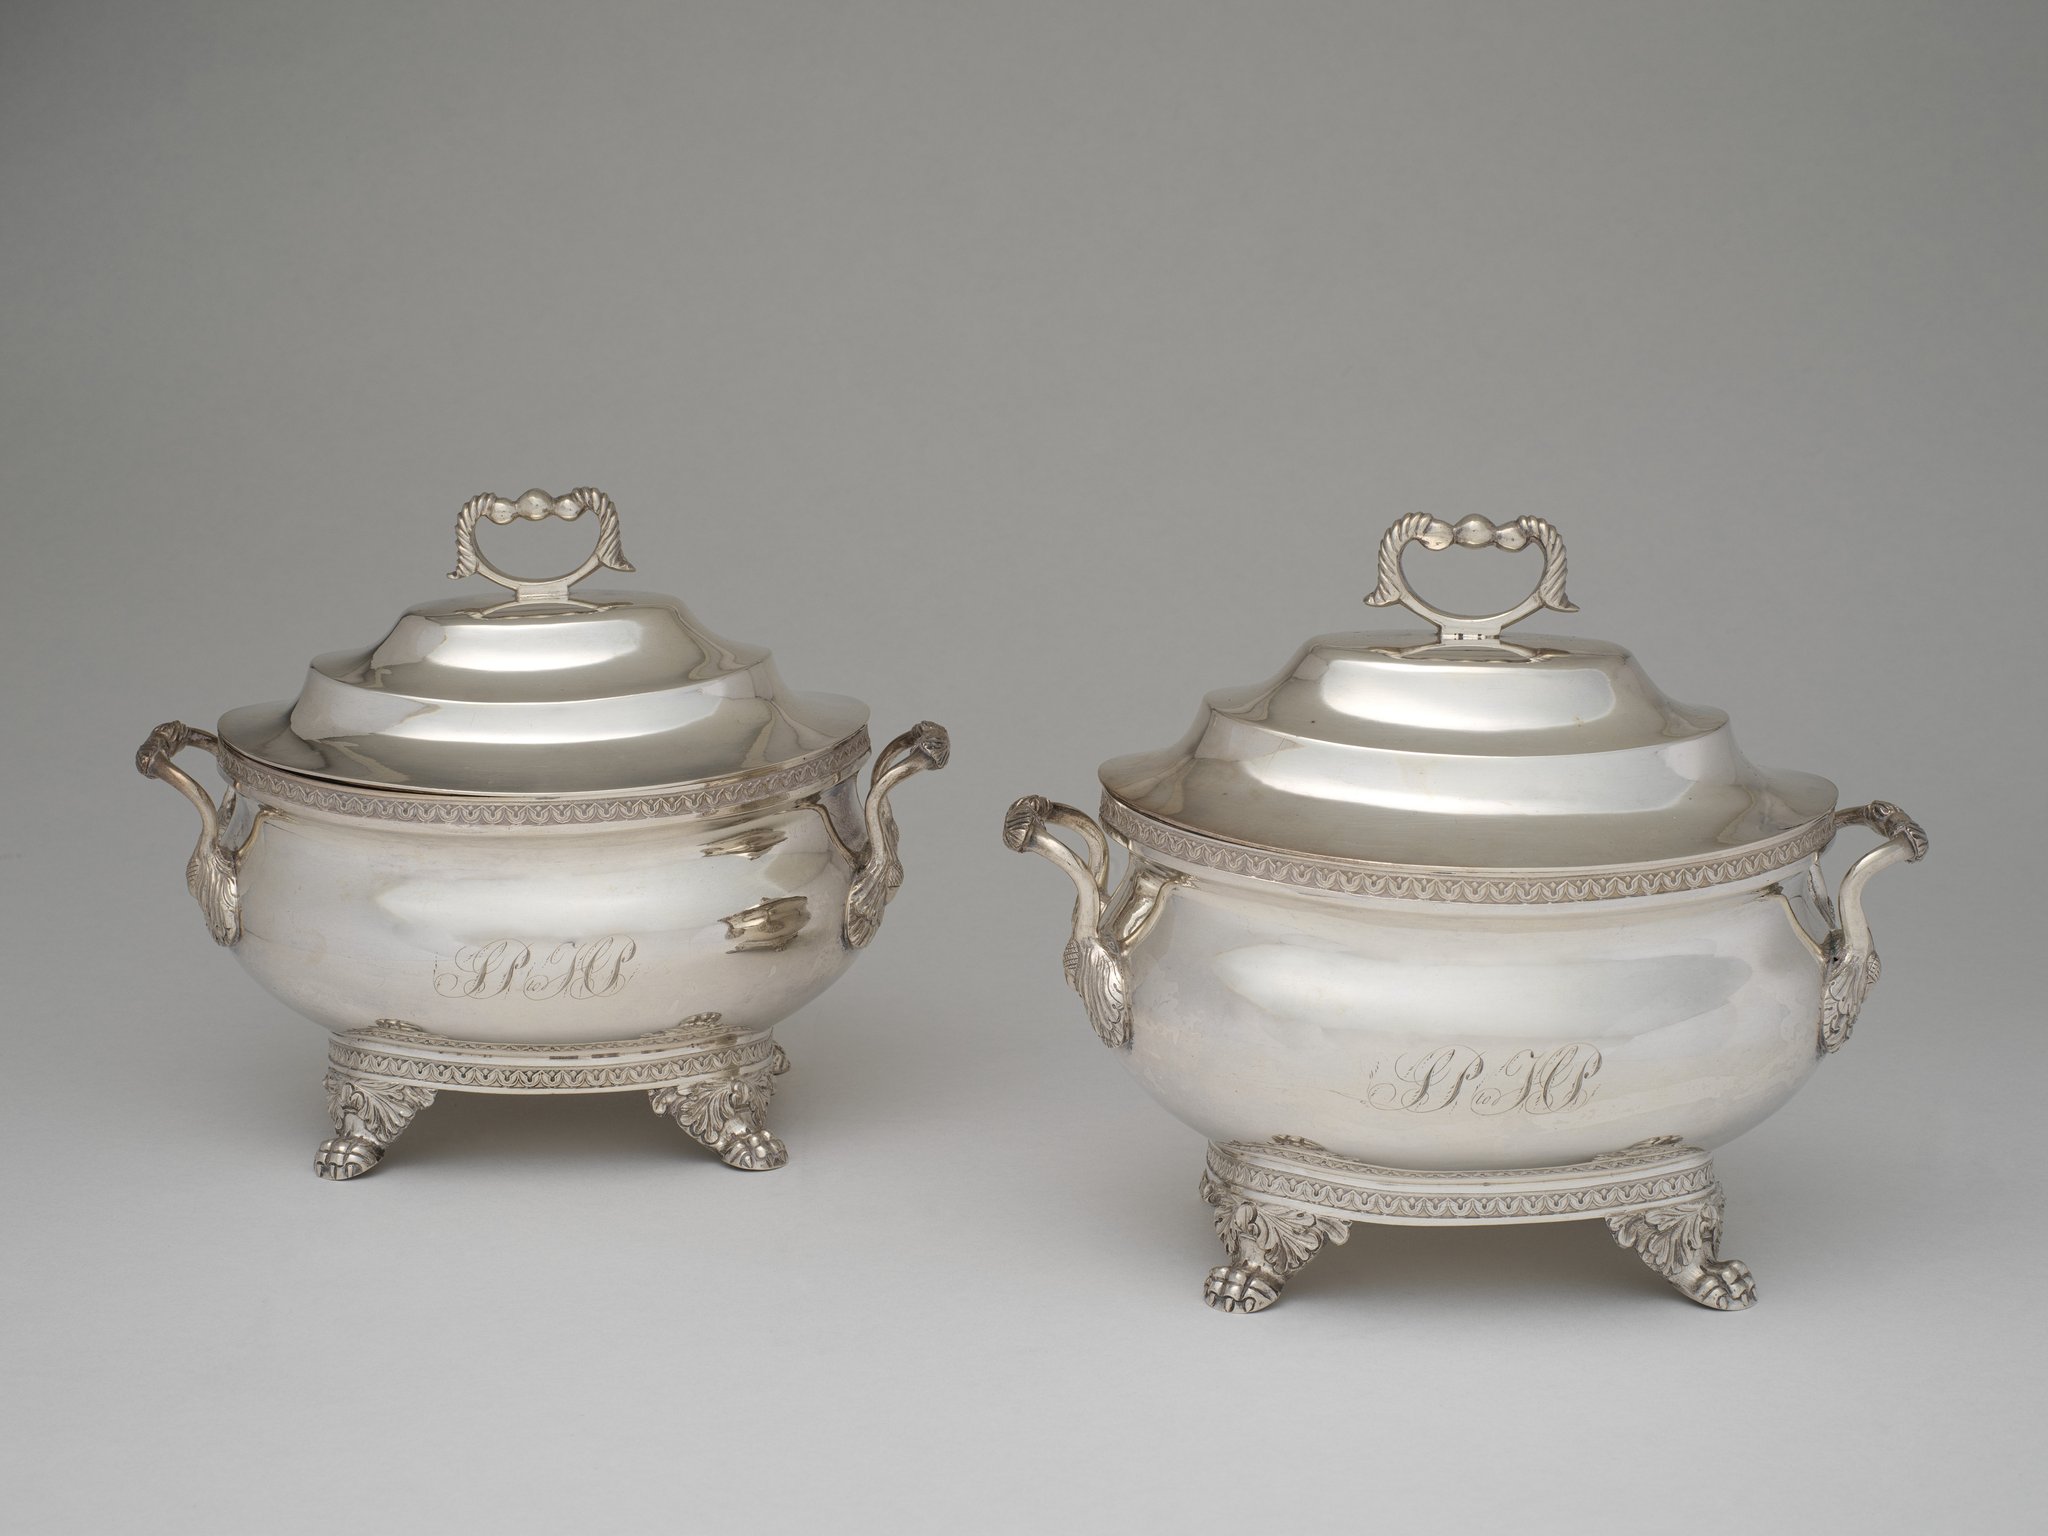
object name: tureen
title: Covered Sauce Tureen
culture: american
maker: edward lownes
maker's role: maker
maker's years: 1792-1834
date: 1817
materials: silver